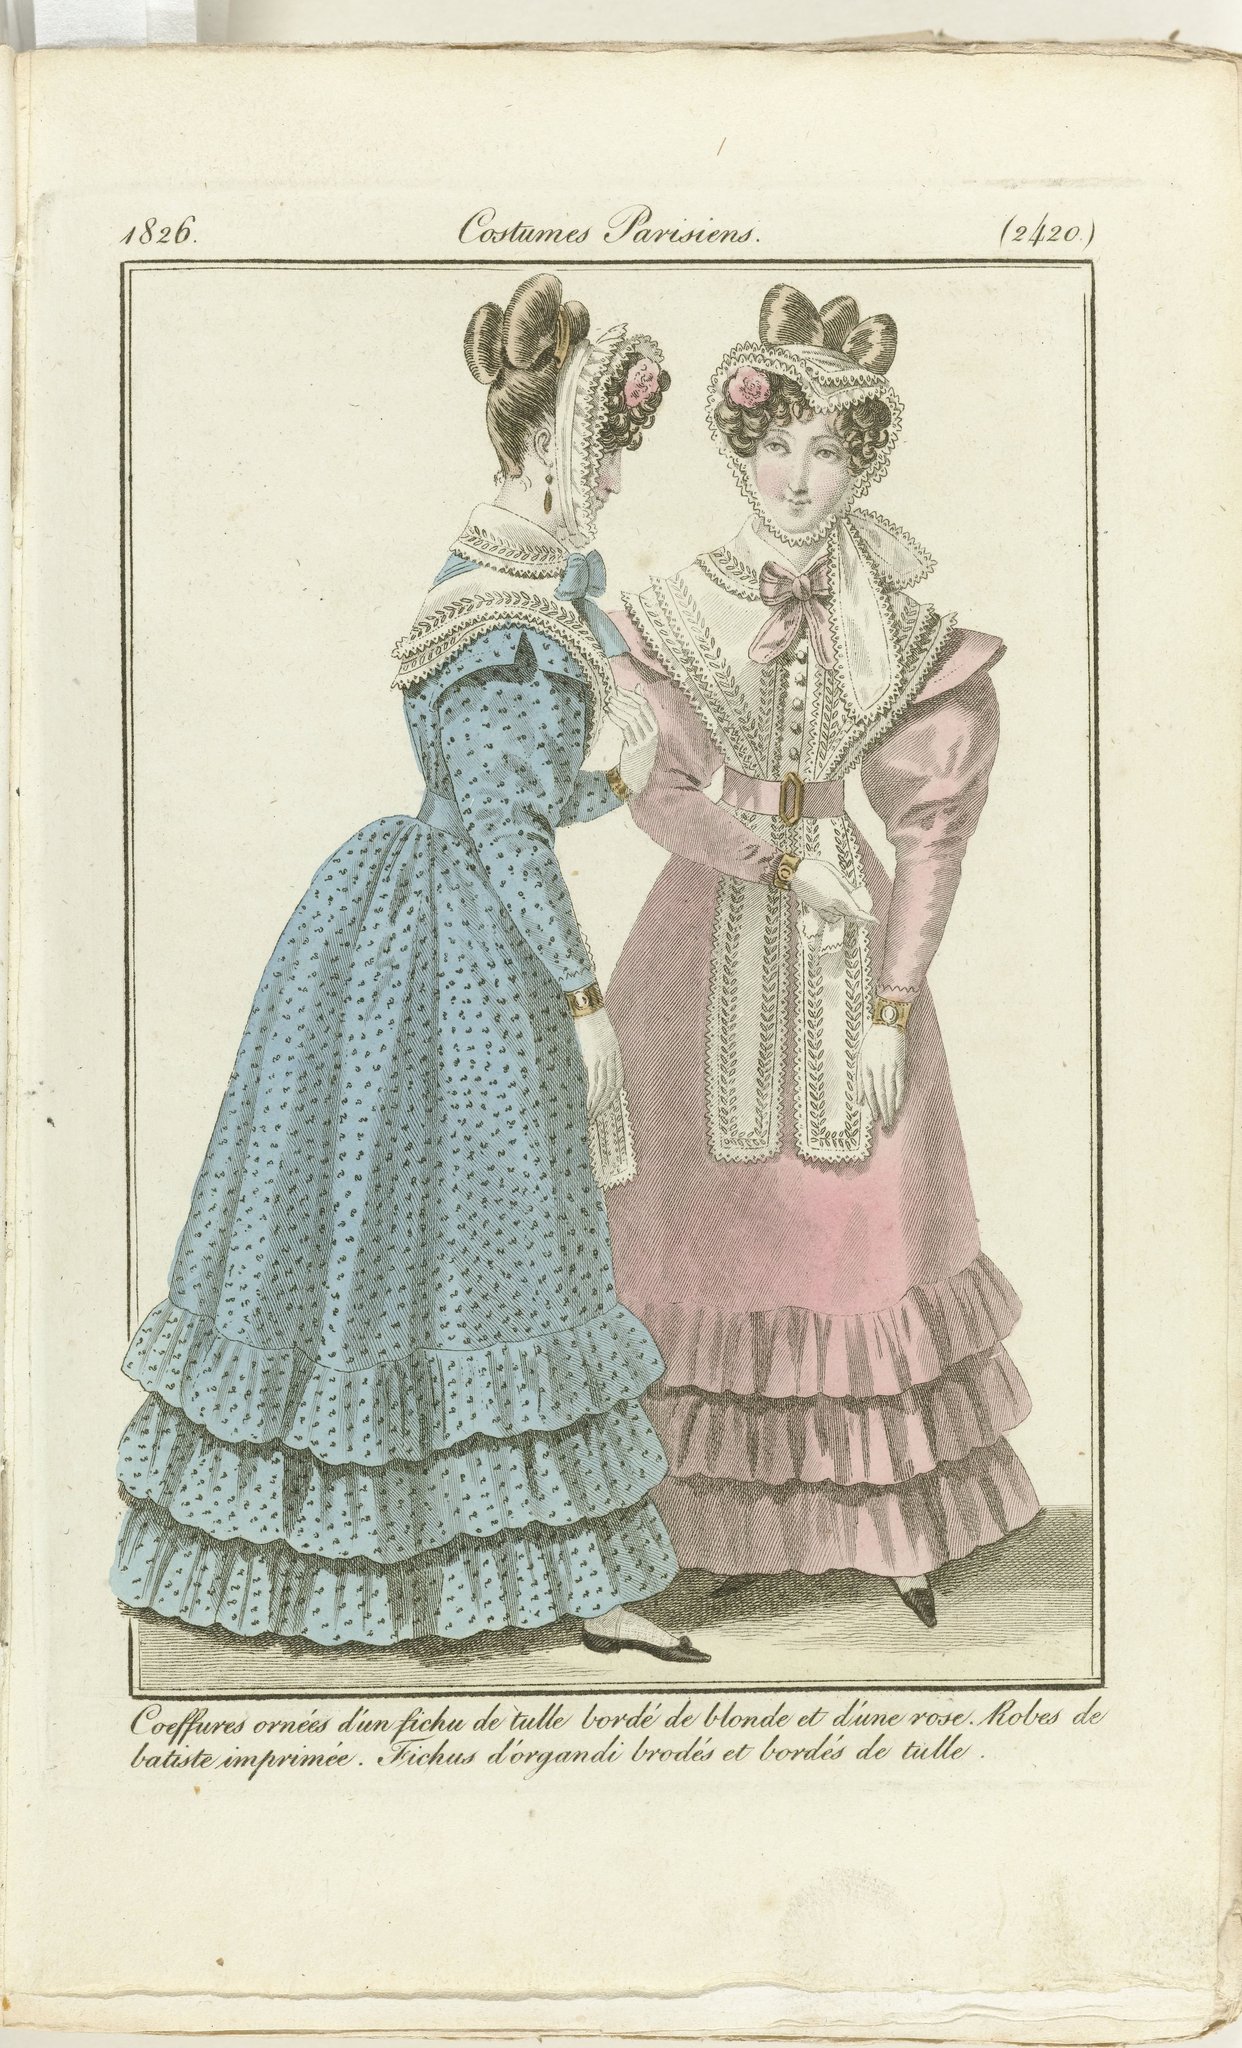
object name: fashion print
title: Journal des dames et des modes 1826, Costumes Parisiens (2420)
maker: Anonymous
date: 1826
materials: paper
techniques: etching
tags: fashion plates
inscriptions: date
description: Coeffure ornées d'un fichu de tulle bordé de blonde et d'une rose. Robes de batiste imprimée. Fichus d'organdi brodés et bordé de tulle.